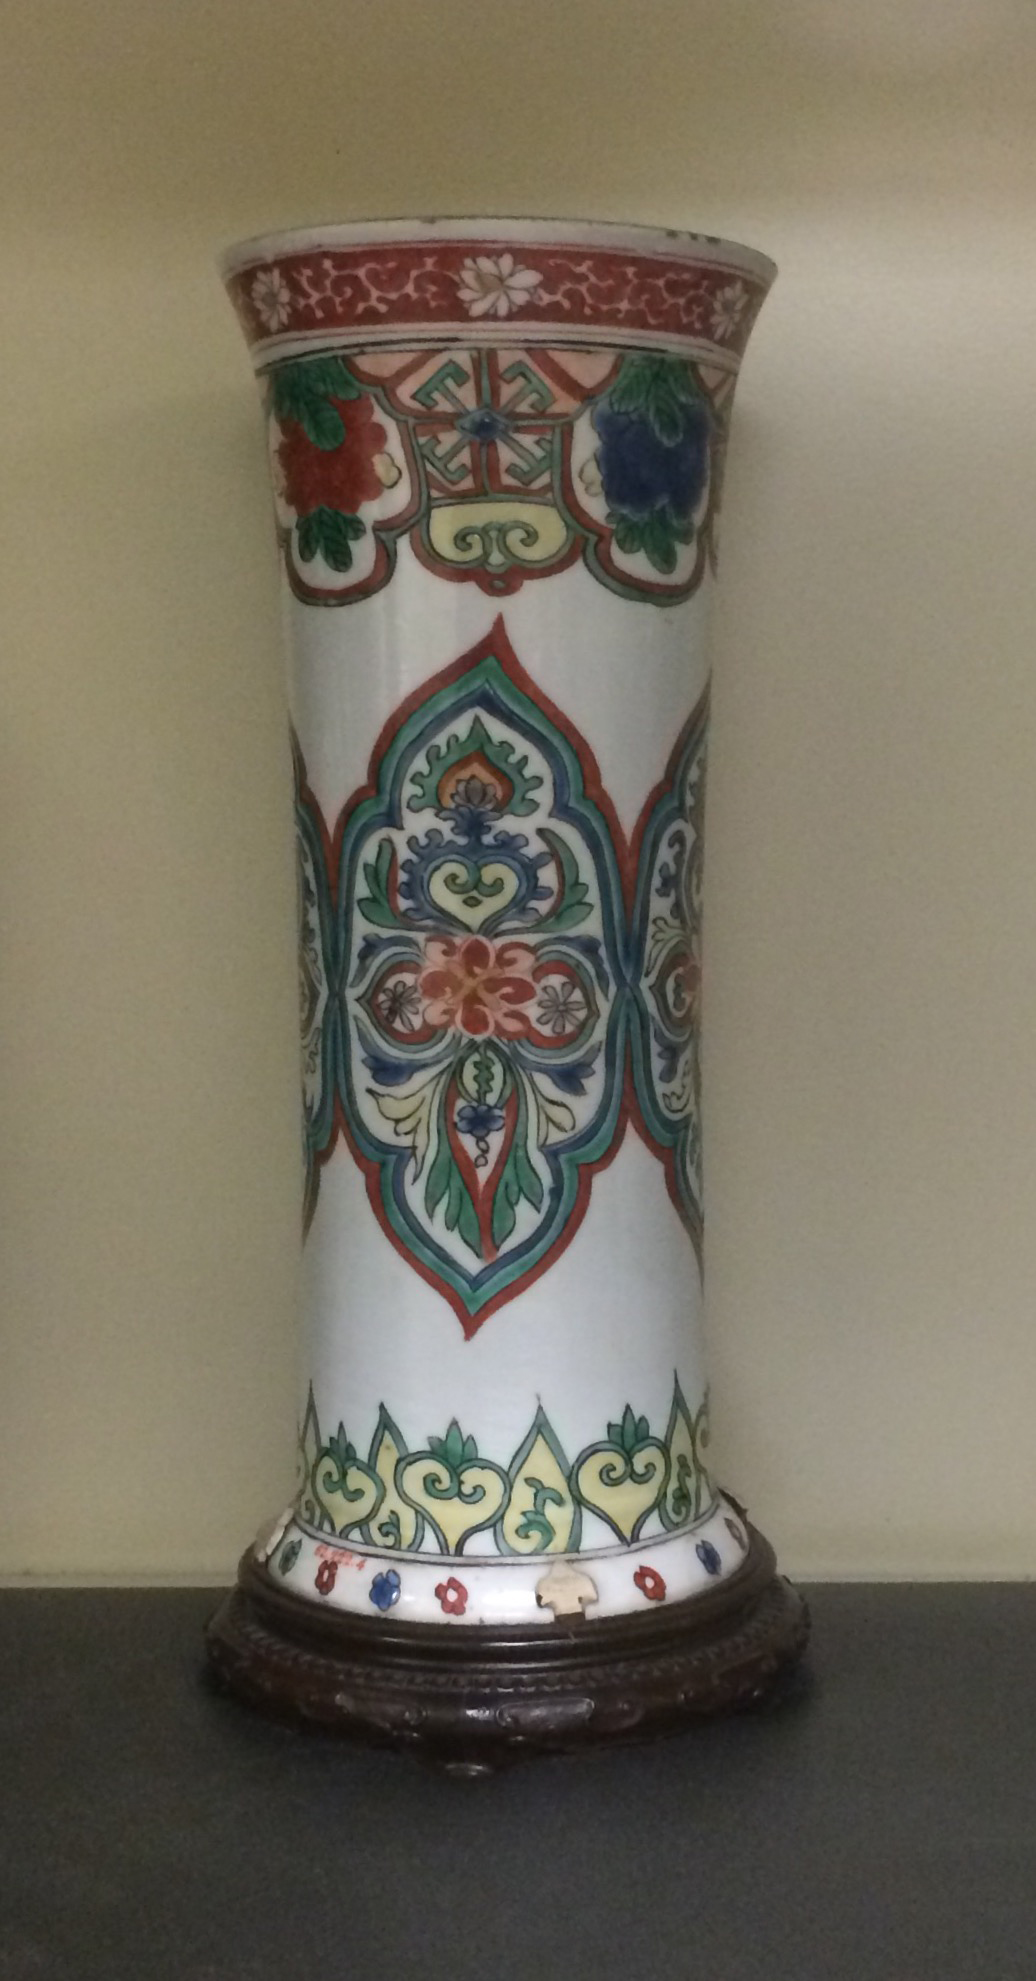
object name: vase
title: Vase (one of a pair)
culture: chinese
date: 1667-1733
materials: enamel, porcelain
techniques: overglaze, painting, polychrome